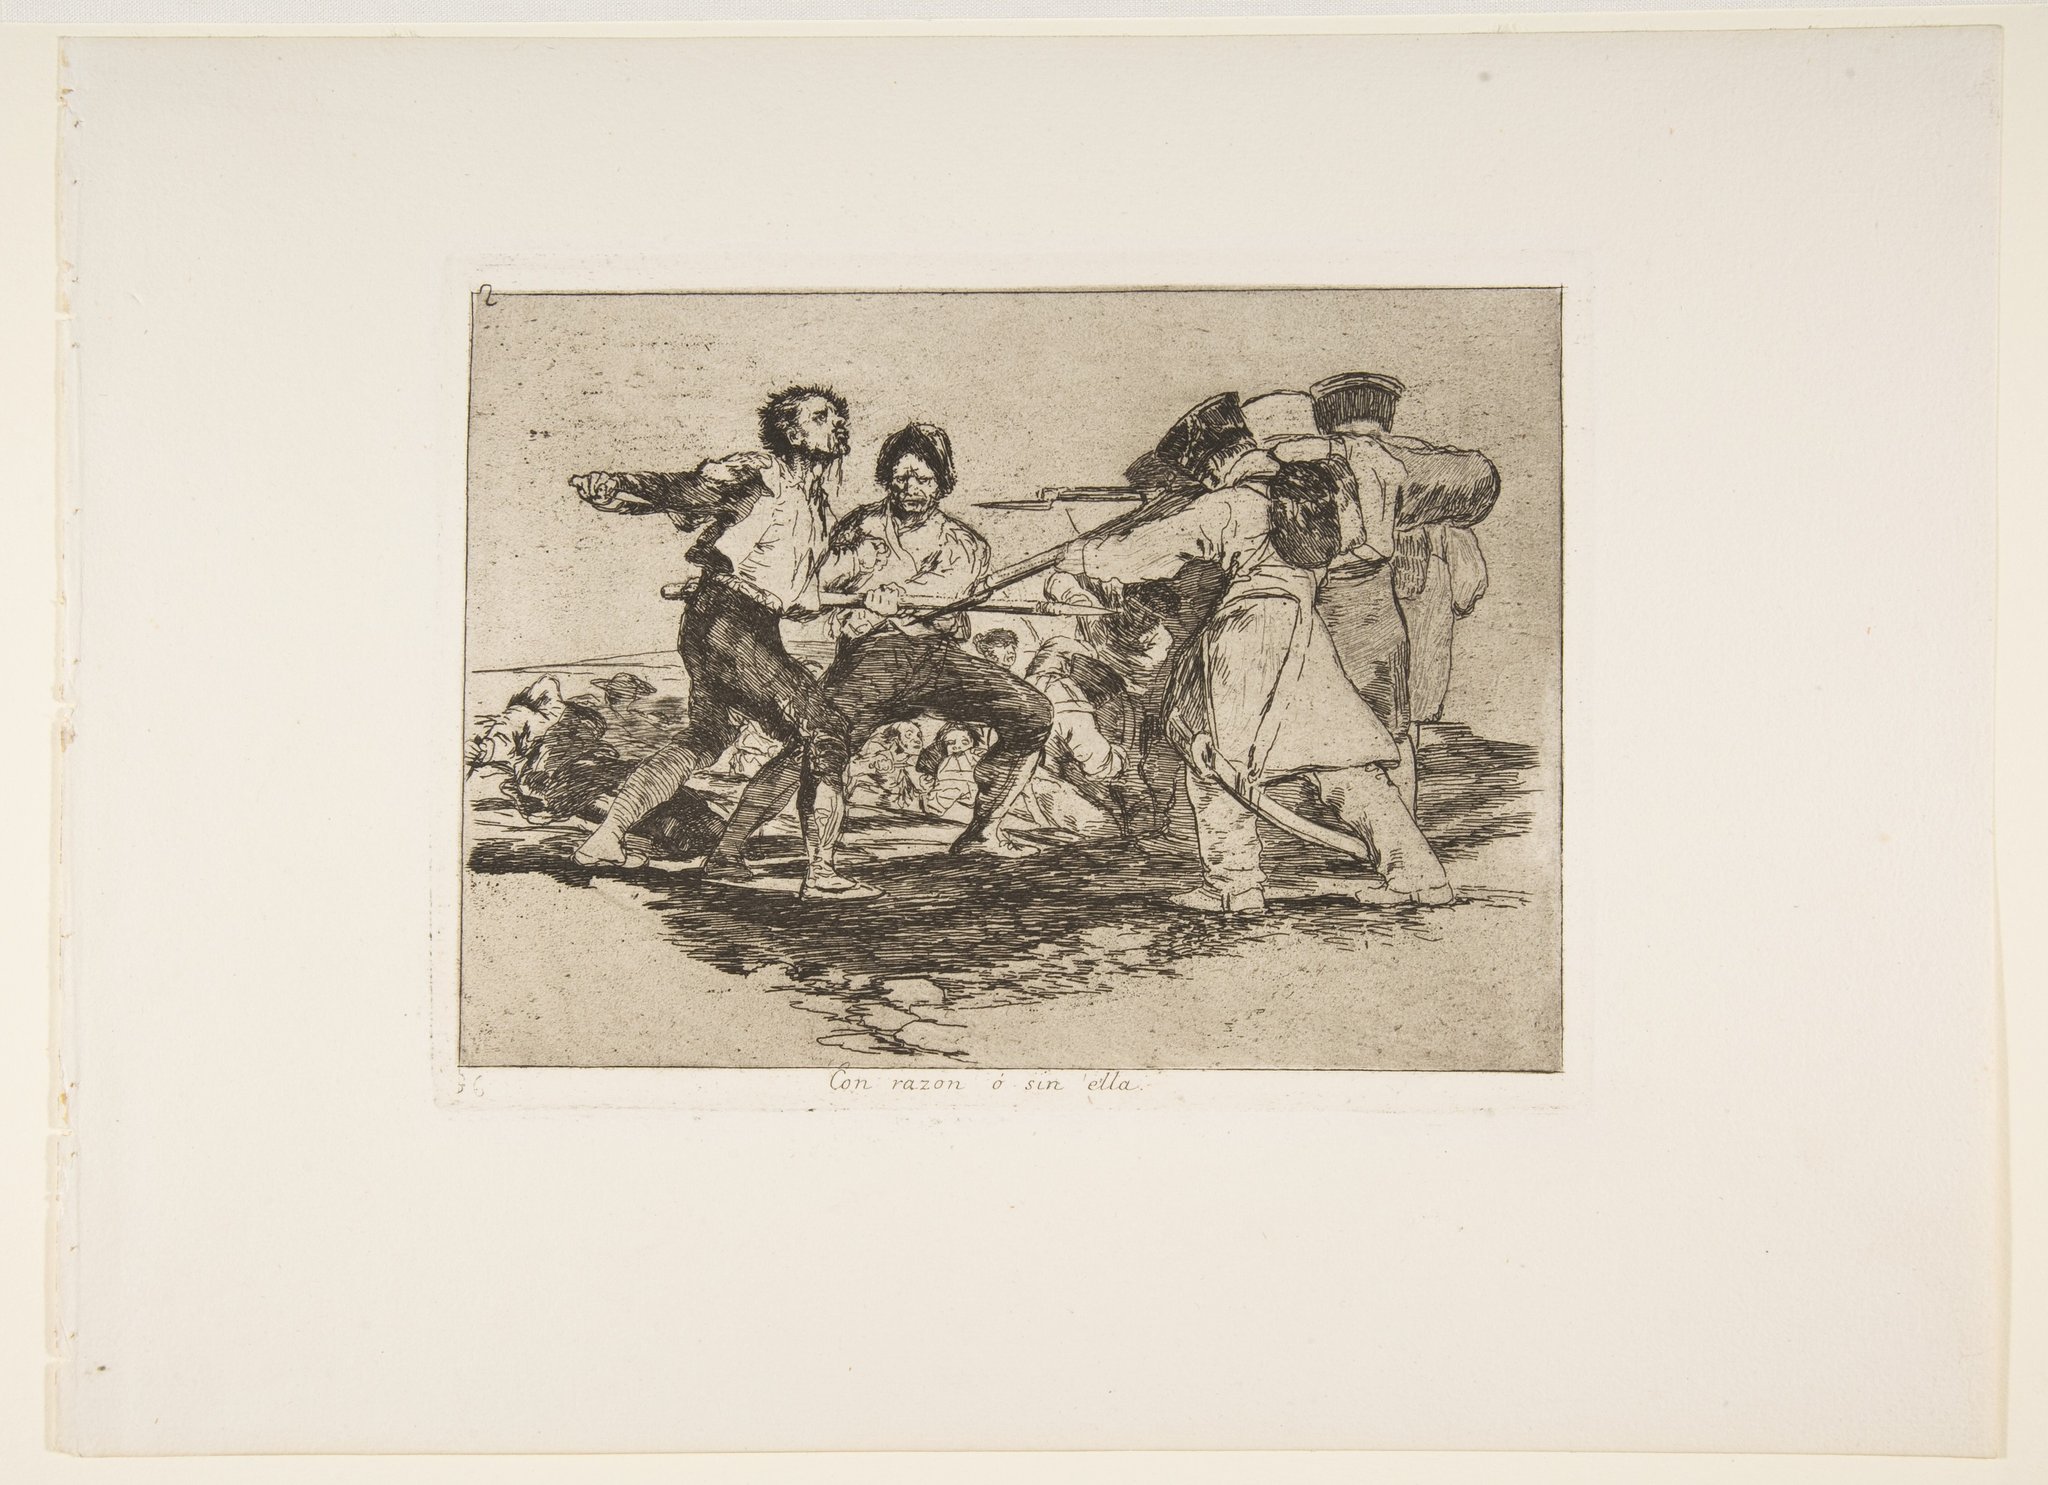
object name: print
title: Plate 2 from "The Disasters of War" (Los Desastres de la Guerra): 'Rightly or wrongly' (Con razon ó sin ella)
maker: goya (francisco de goya y lucientes)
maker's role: artist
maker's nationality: spanish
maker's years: 1746-1828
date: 1810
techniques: engraving, drypoint, etching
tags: wars,men